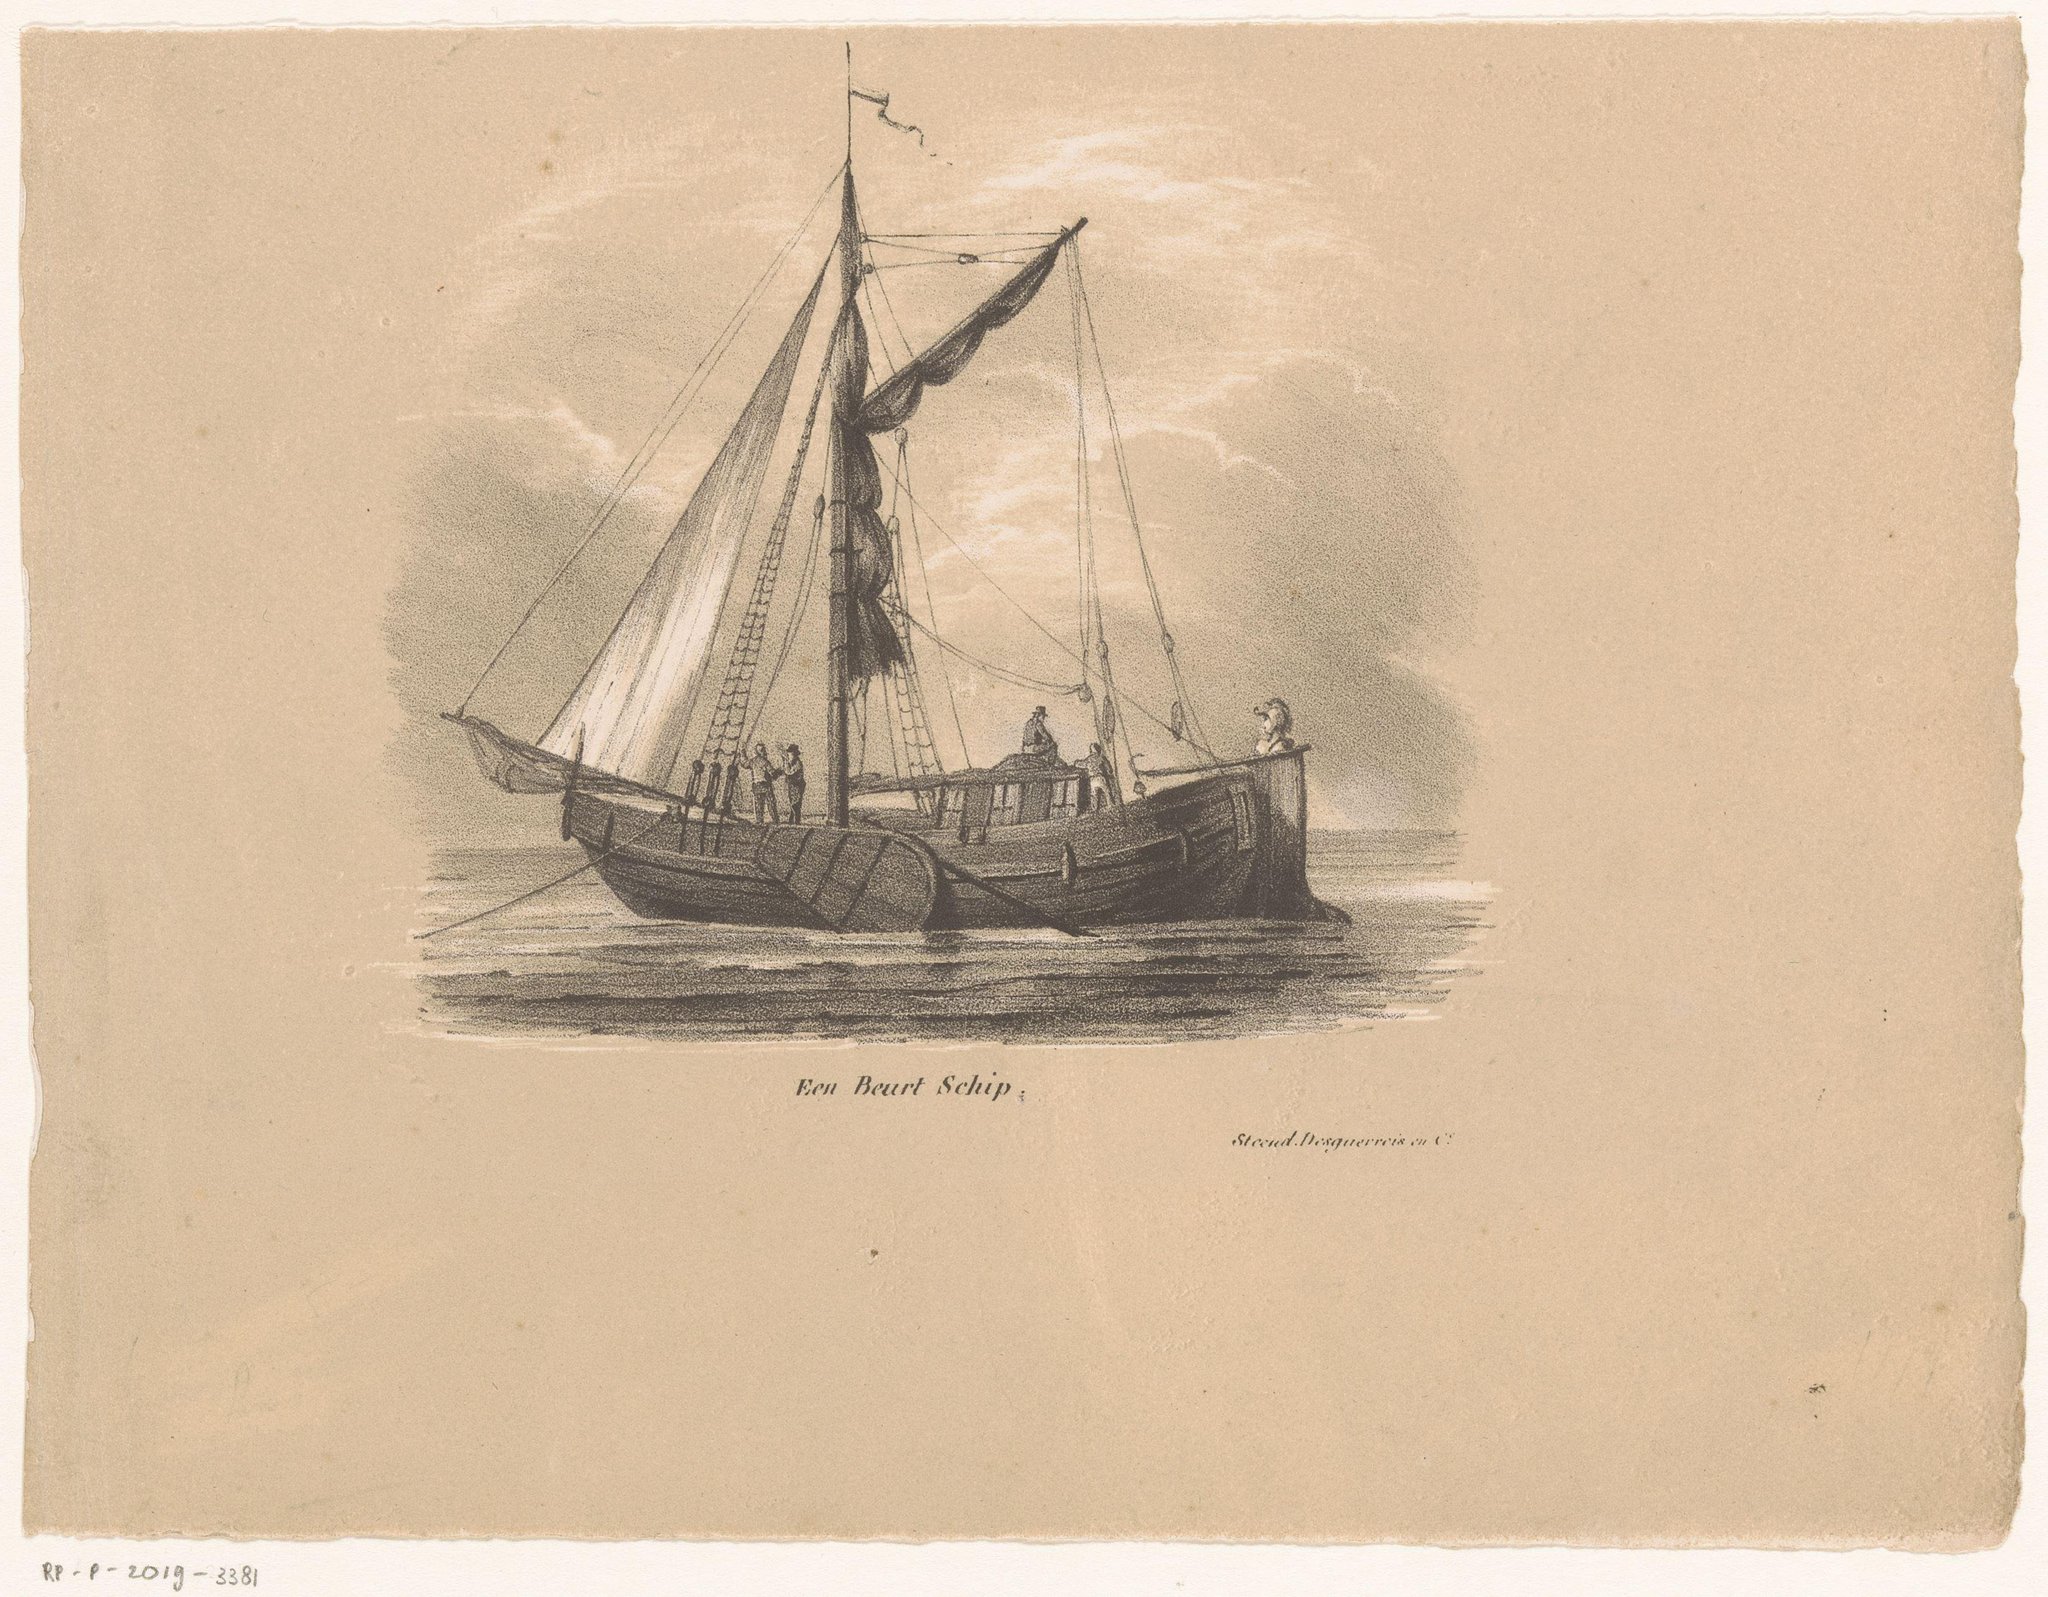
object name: print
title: Scheeps studien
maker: johannes cornelis van pappelendam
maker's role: print maker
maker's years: 1810-1884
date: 1827-1884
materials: paper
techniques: tone lithography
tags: sailing-ship, sailing-boat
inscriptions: collector's mark: Lugt 2228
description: Maakt deel uit van een serie met scheepsstudies.